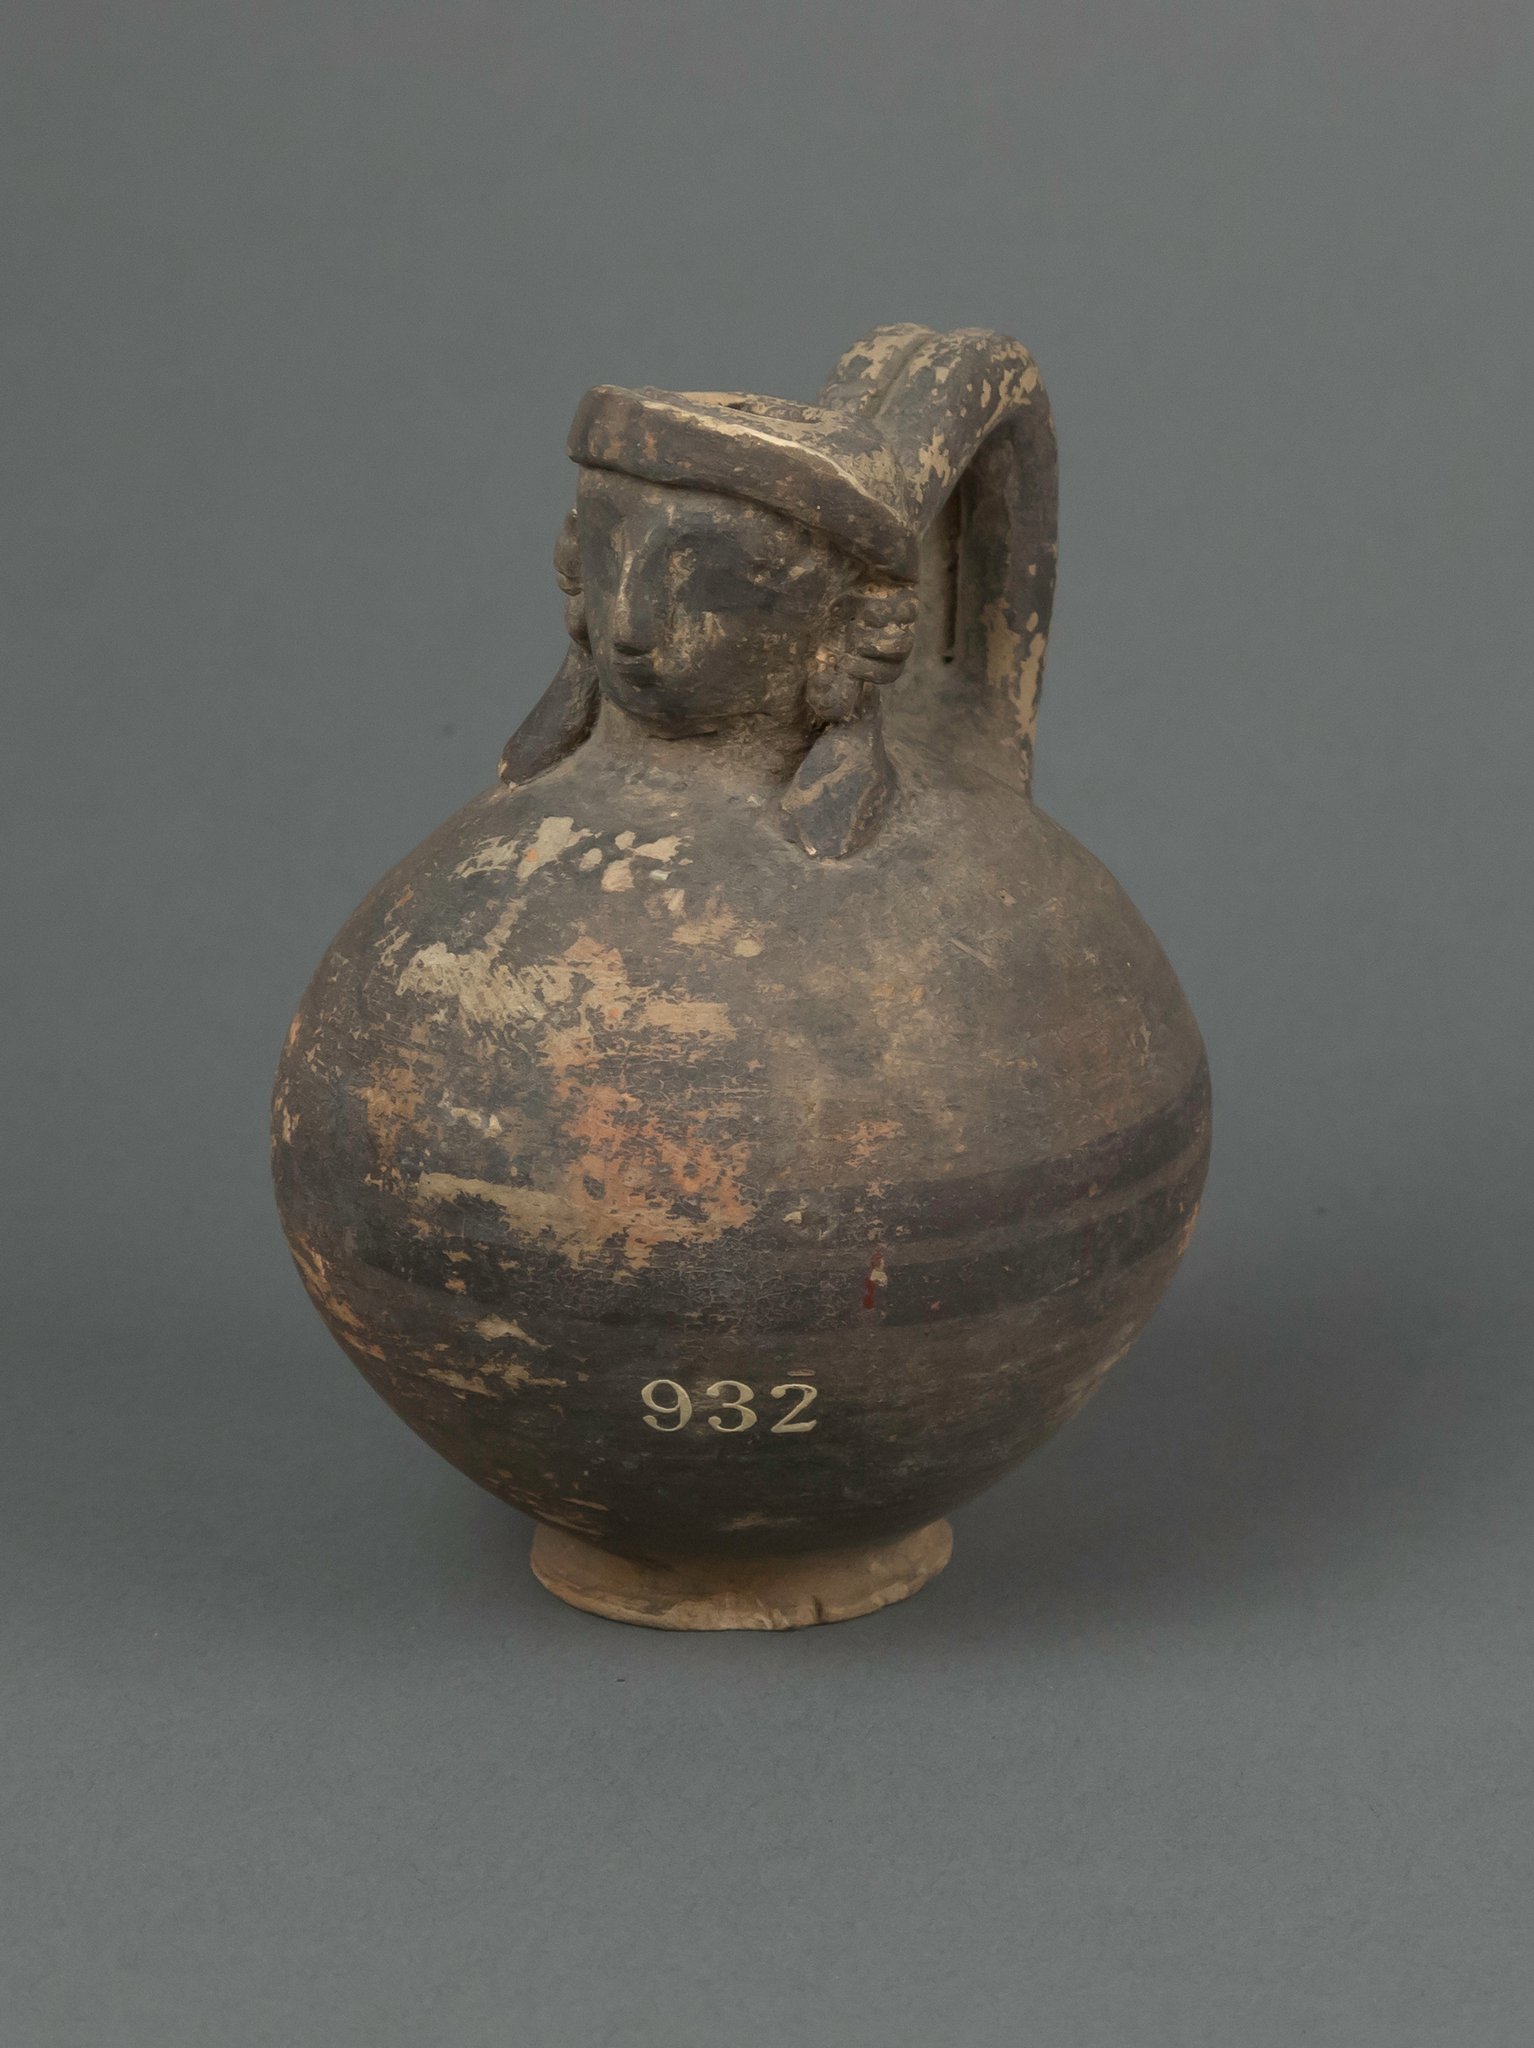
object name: juglet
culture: cypriot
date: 750-600 BCE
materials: terracotta